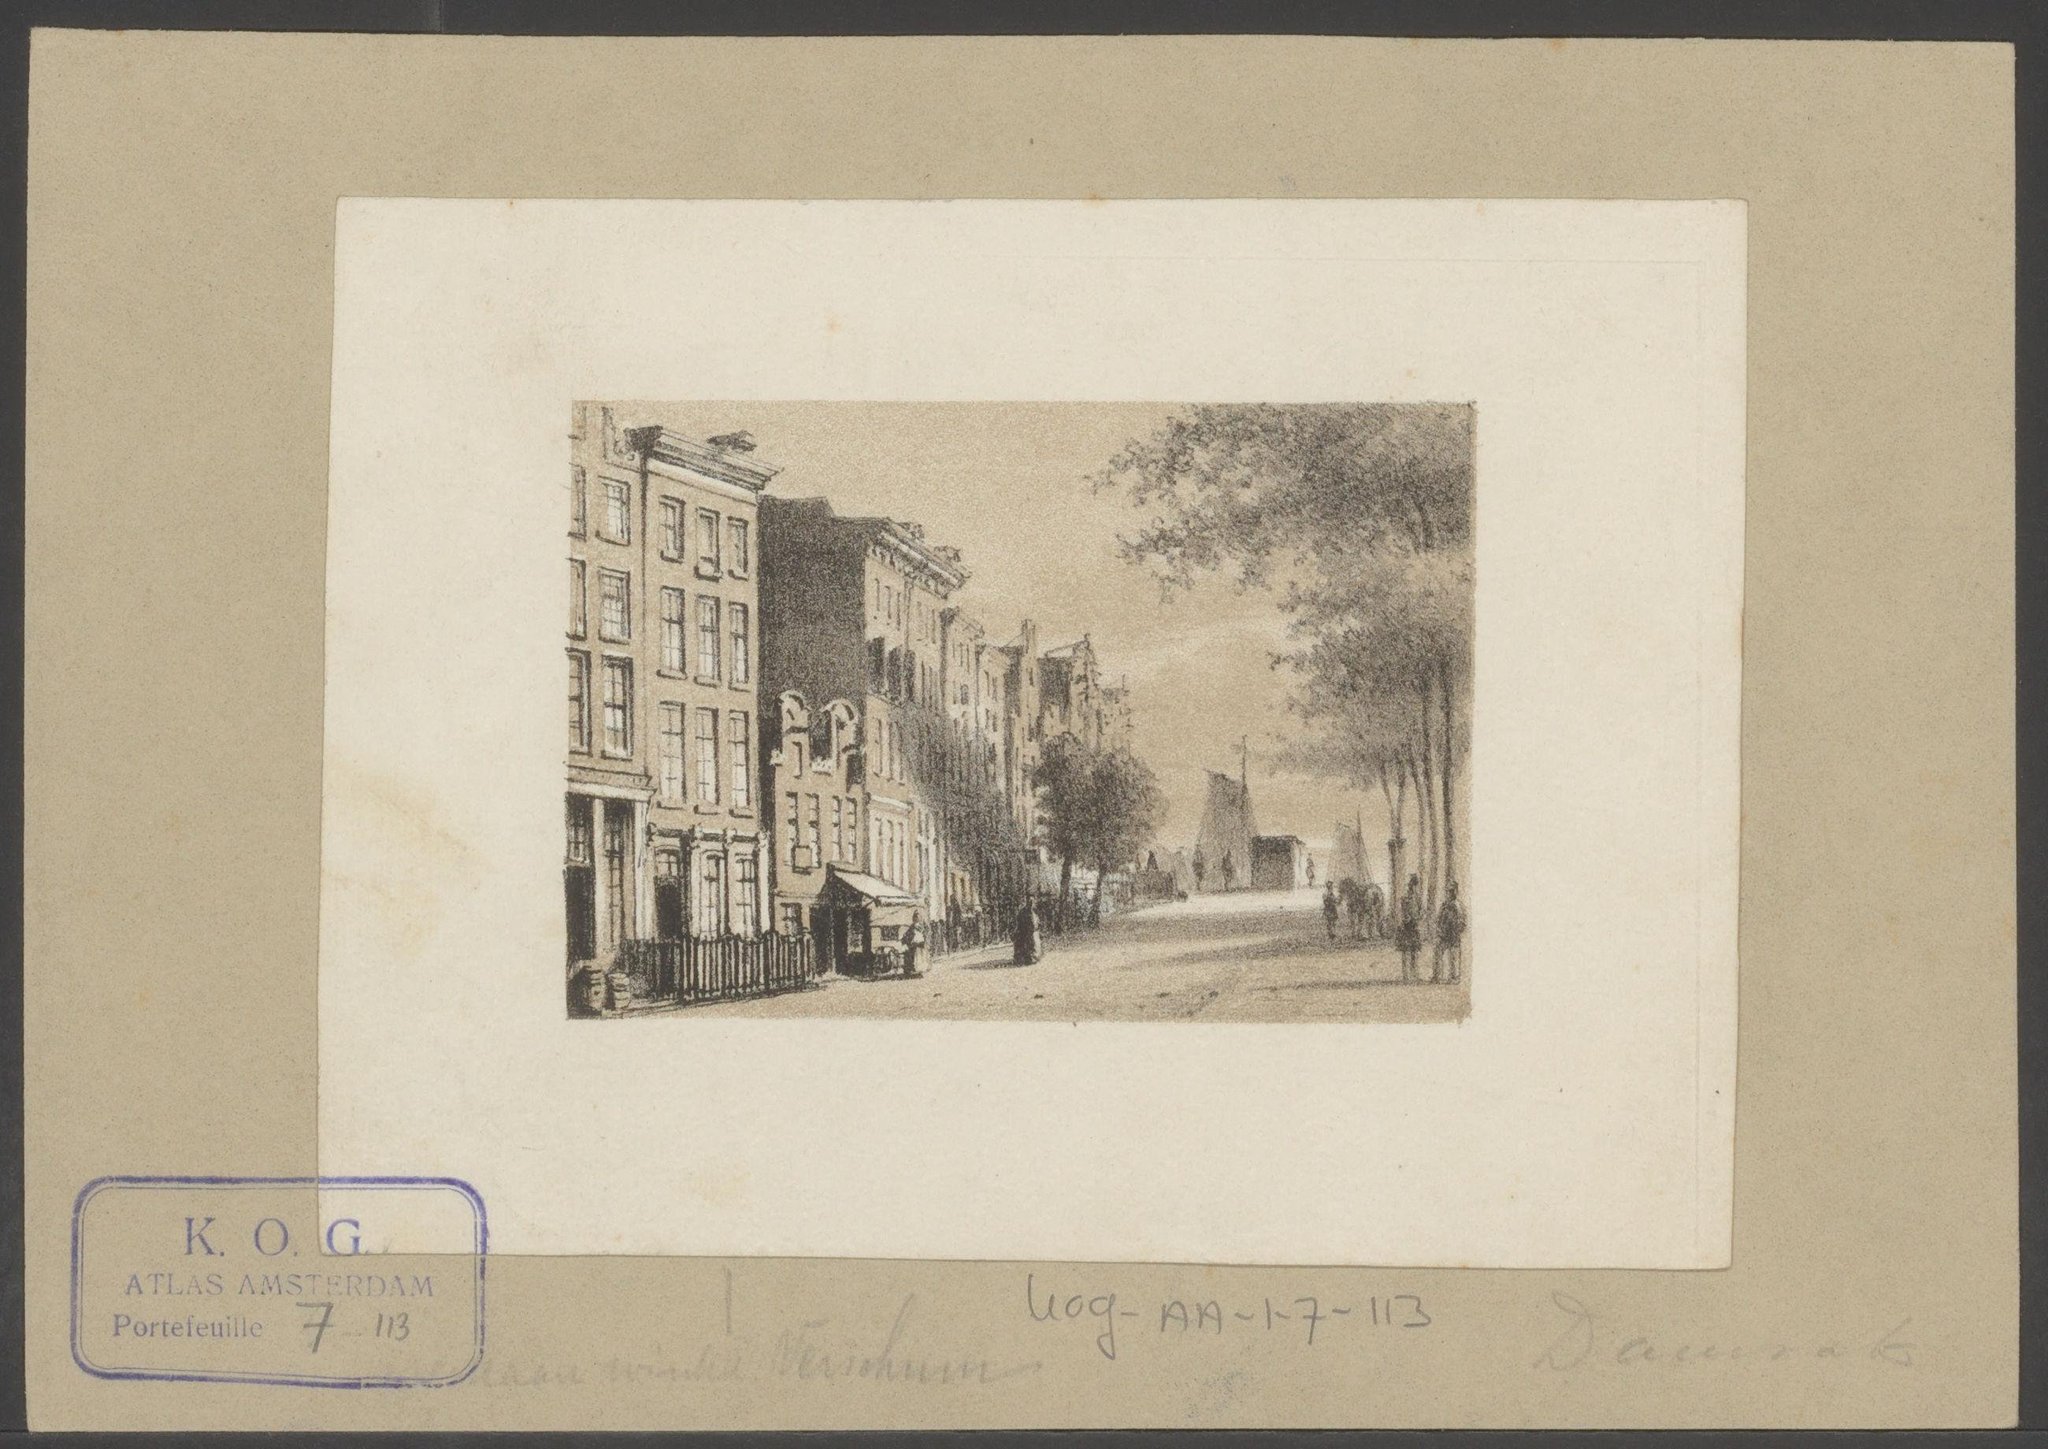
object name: print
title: Gezicht op het Damrak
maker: Anonymous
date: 1800-1899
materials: paper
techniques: tone lithography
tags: shop, store, city-view in general; 'veduta', canal, the usual house or row of houses, bridge in city across river, canal, etc.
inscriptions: collector's mark: ‘7’ Lugt 1641b, inscription: ‘Geschenk van den heer / Lanting’, inscription: ‘[...]aar winkel Verschuur / Damrak’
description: Onderwerpsrubriek binnen de Atlas Amsterdam: Damrak, Damstraat, Doelensluis, Doelenstraat (Nieuwe), Driehoekstraat, Droogbak, Duvelshoek, Dijkstraat en Korte -.